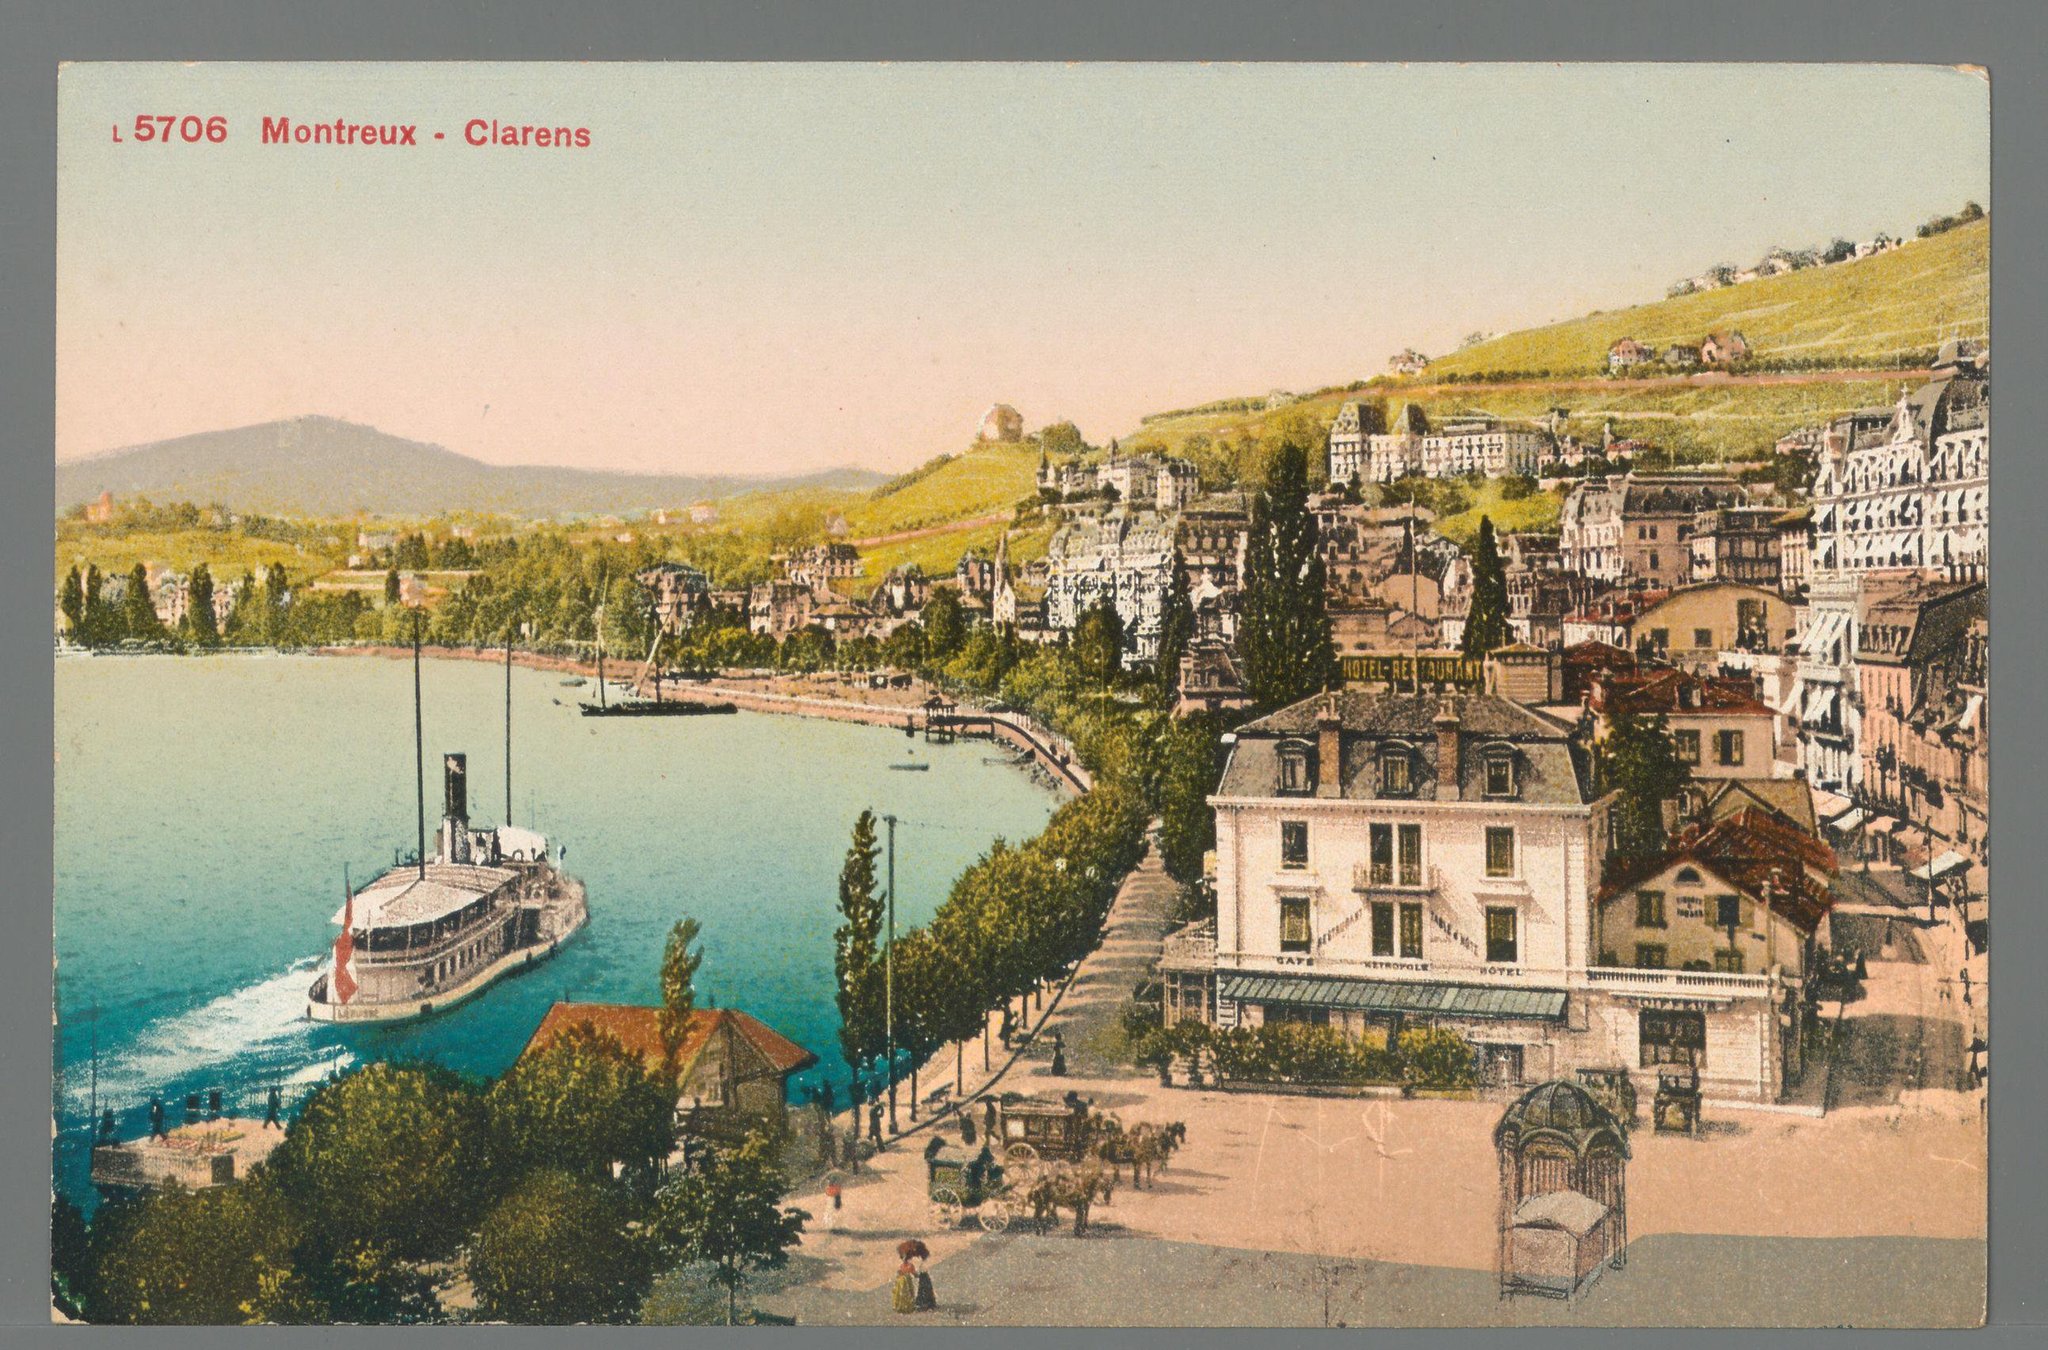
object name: photomechanical print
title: Montreux. Clarens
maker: Anonymous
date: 1905-1920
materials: cardboard, photographic process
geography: zurich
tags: square, place, circus, etc., prospect of city, town panorama, silhouette of city (+ city(-scape) with figures, staffage)